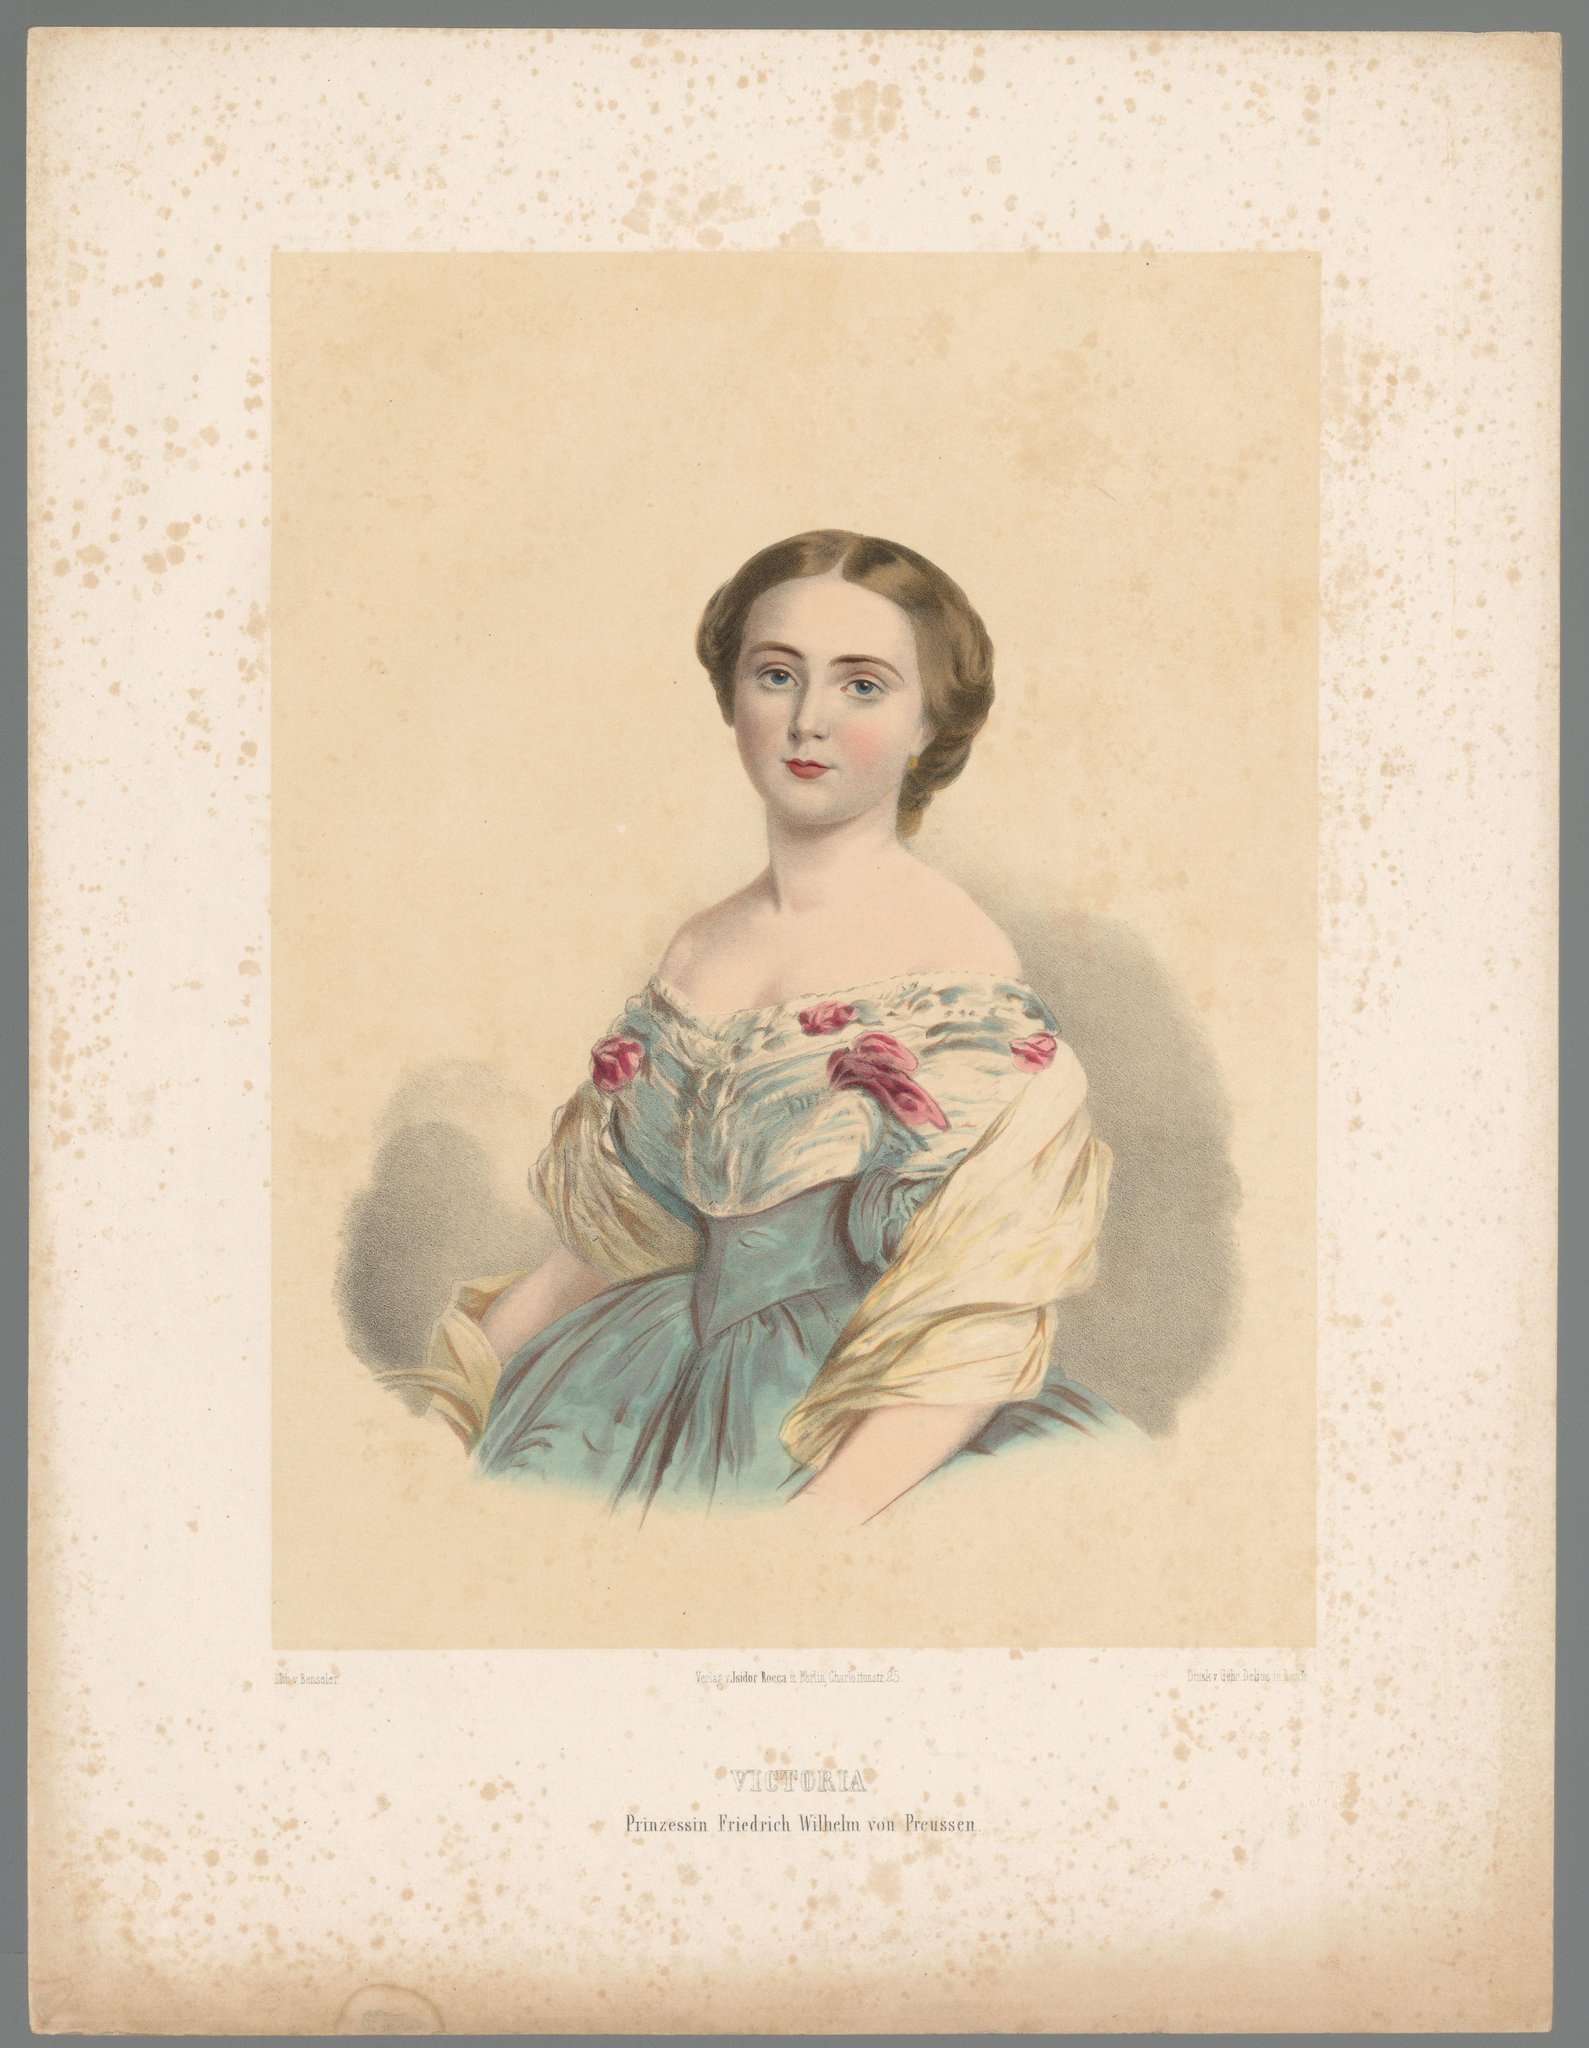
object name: print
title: Portret van Victoria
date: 1850-1899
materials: paper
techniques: hand coloring, lithograph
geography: berlin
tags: victoria van saksen-coburg en gotha (duits keizerin), adult woman, historical persons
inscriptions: check stamp: ‘Kunsthandlung I. Rocca Berlin’, collector's mark: Lugt 2228